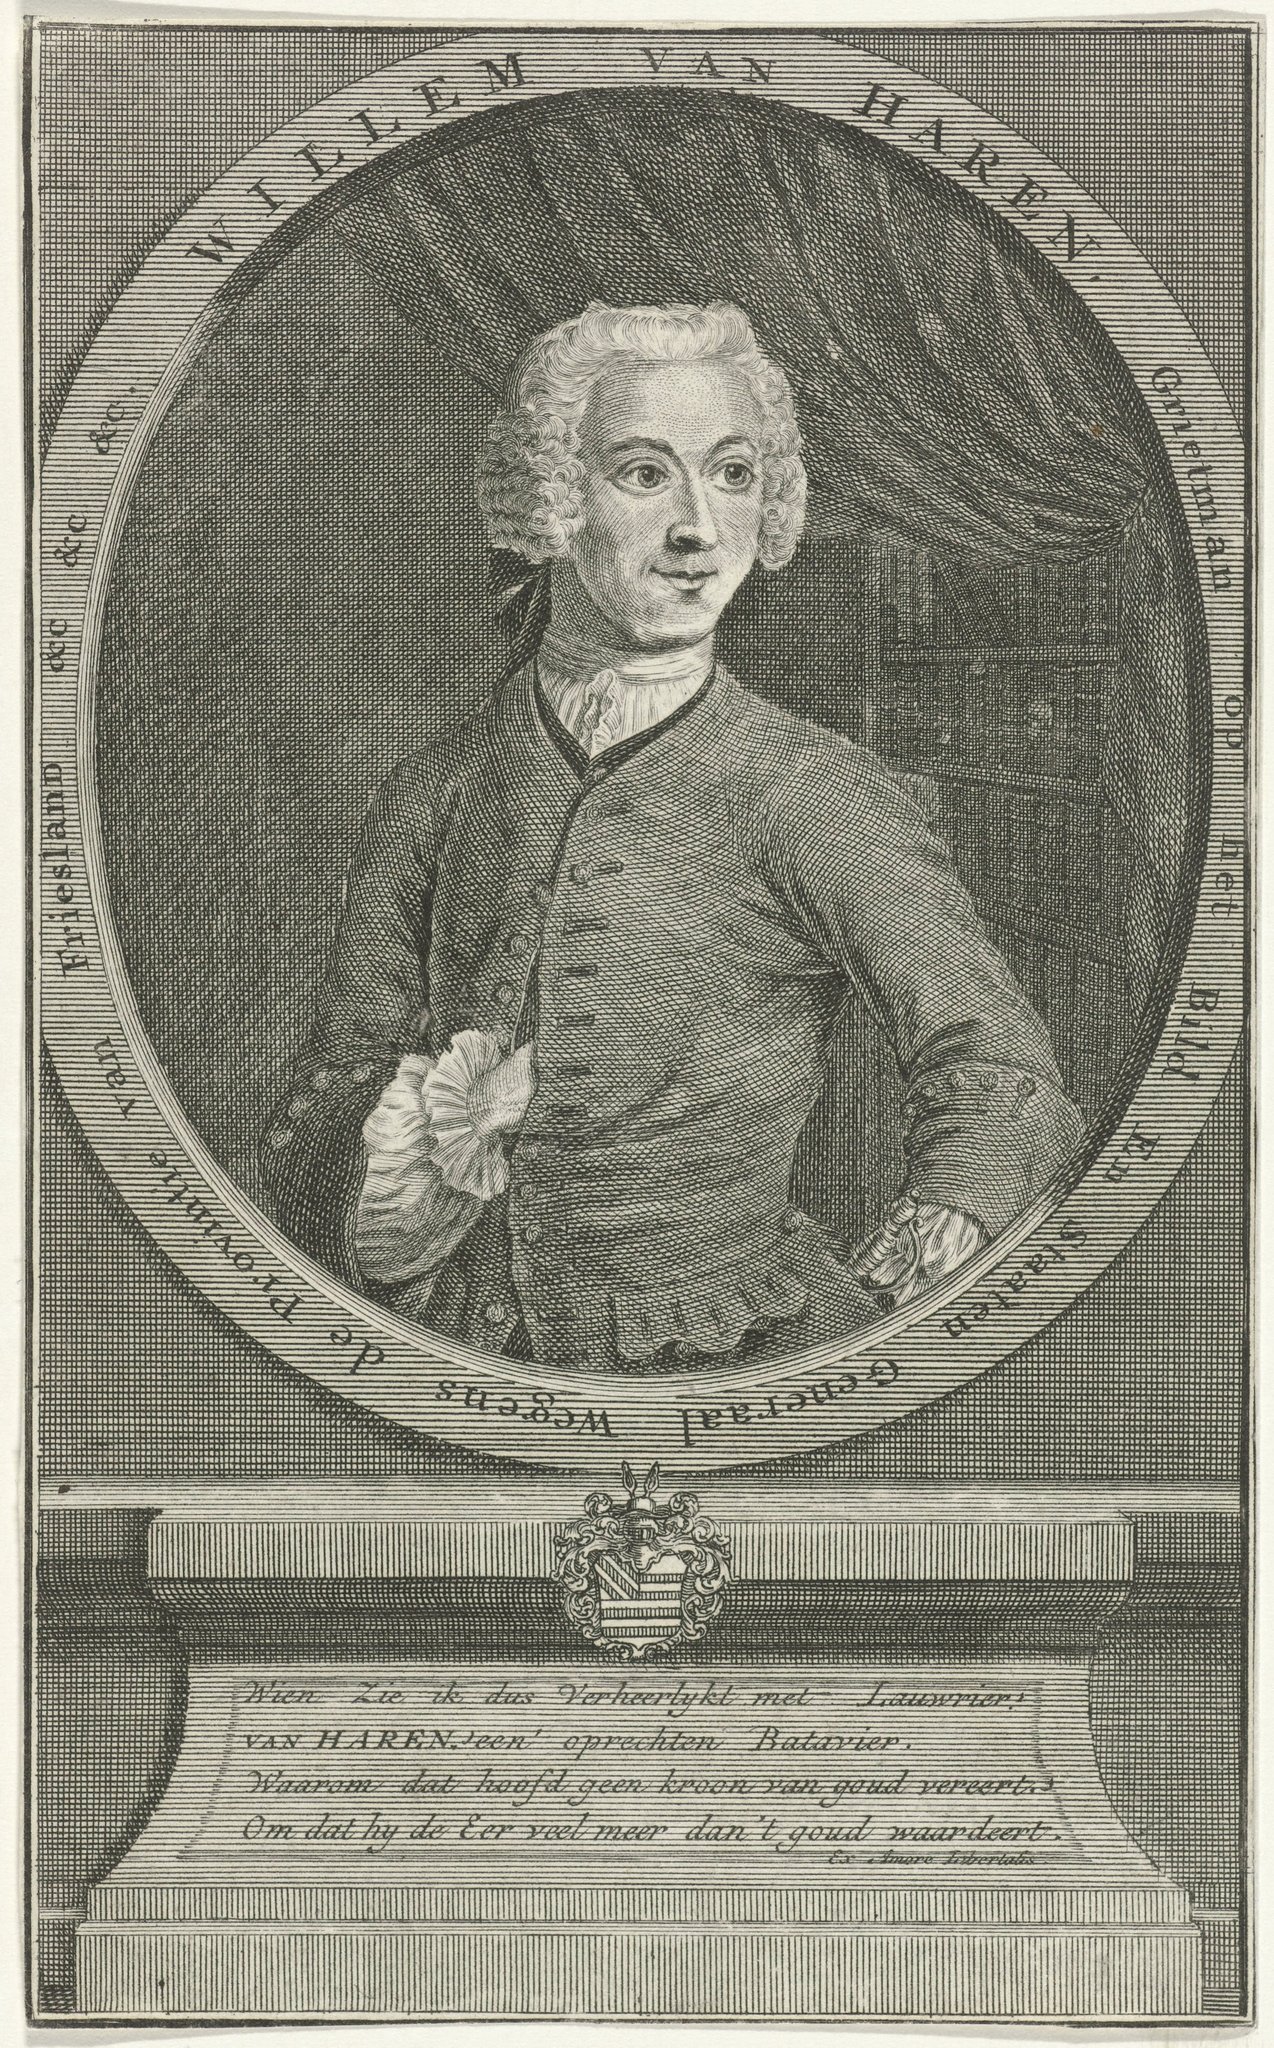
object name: print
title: Portret van Willem van Haren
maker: coenraad de putter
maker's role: print maker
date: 1729-1744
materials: paper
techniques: engraving, etching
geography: netherlands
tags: leeuwarden, sint-oedenrode, dichter, schrijver, willem van haren (1710-1768)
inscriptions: collector's mark: Lugt 2228, collector's mark: Lugt 2760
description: Portret ten halven lijve naar rechts van Willem van Haren in een ovaal. Het portret rust op een piëdestal waarop zijn wapen en een vierregelig vers.